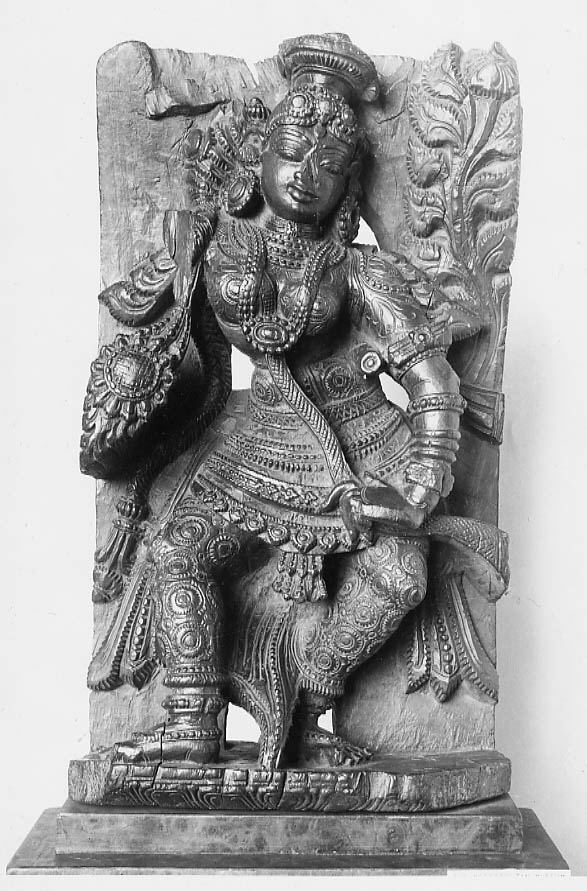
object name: figure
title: Fragment from a Processional Car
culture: indian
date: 1601-1800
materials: wood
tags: women